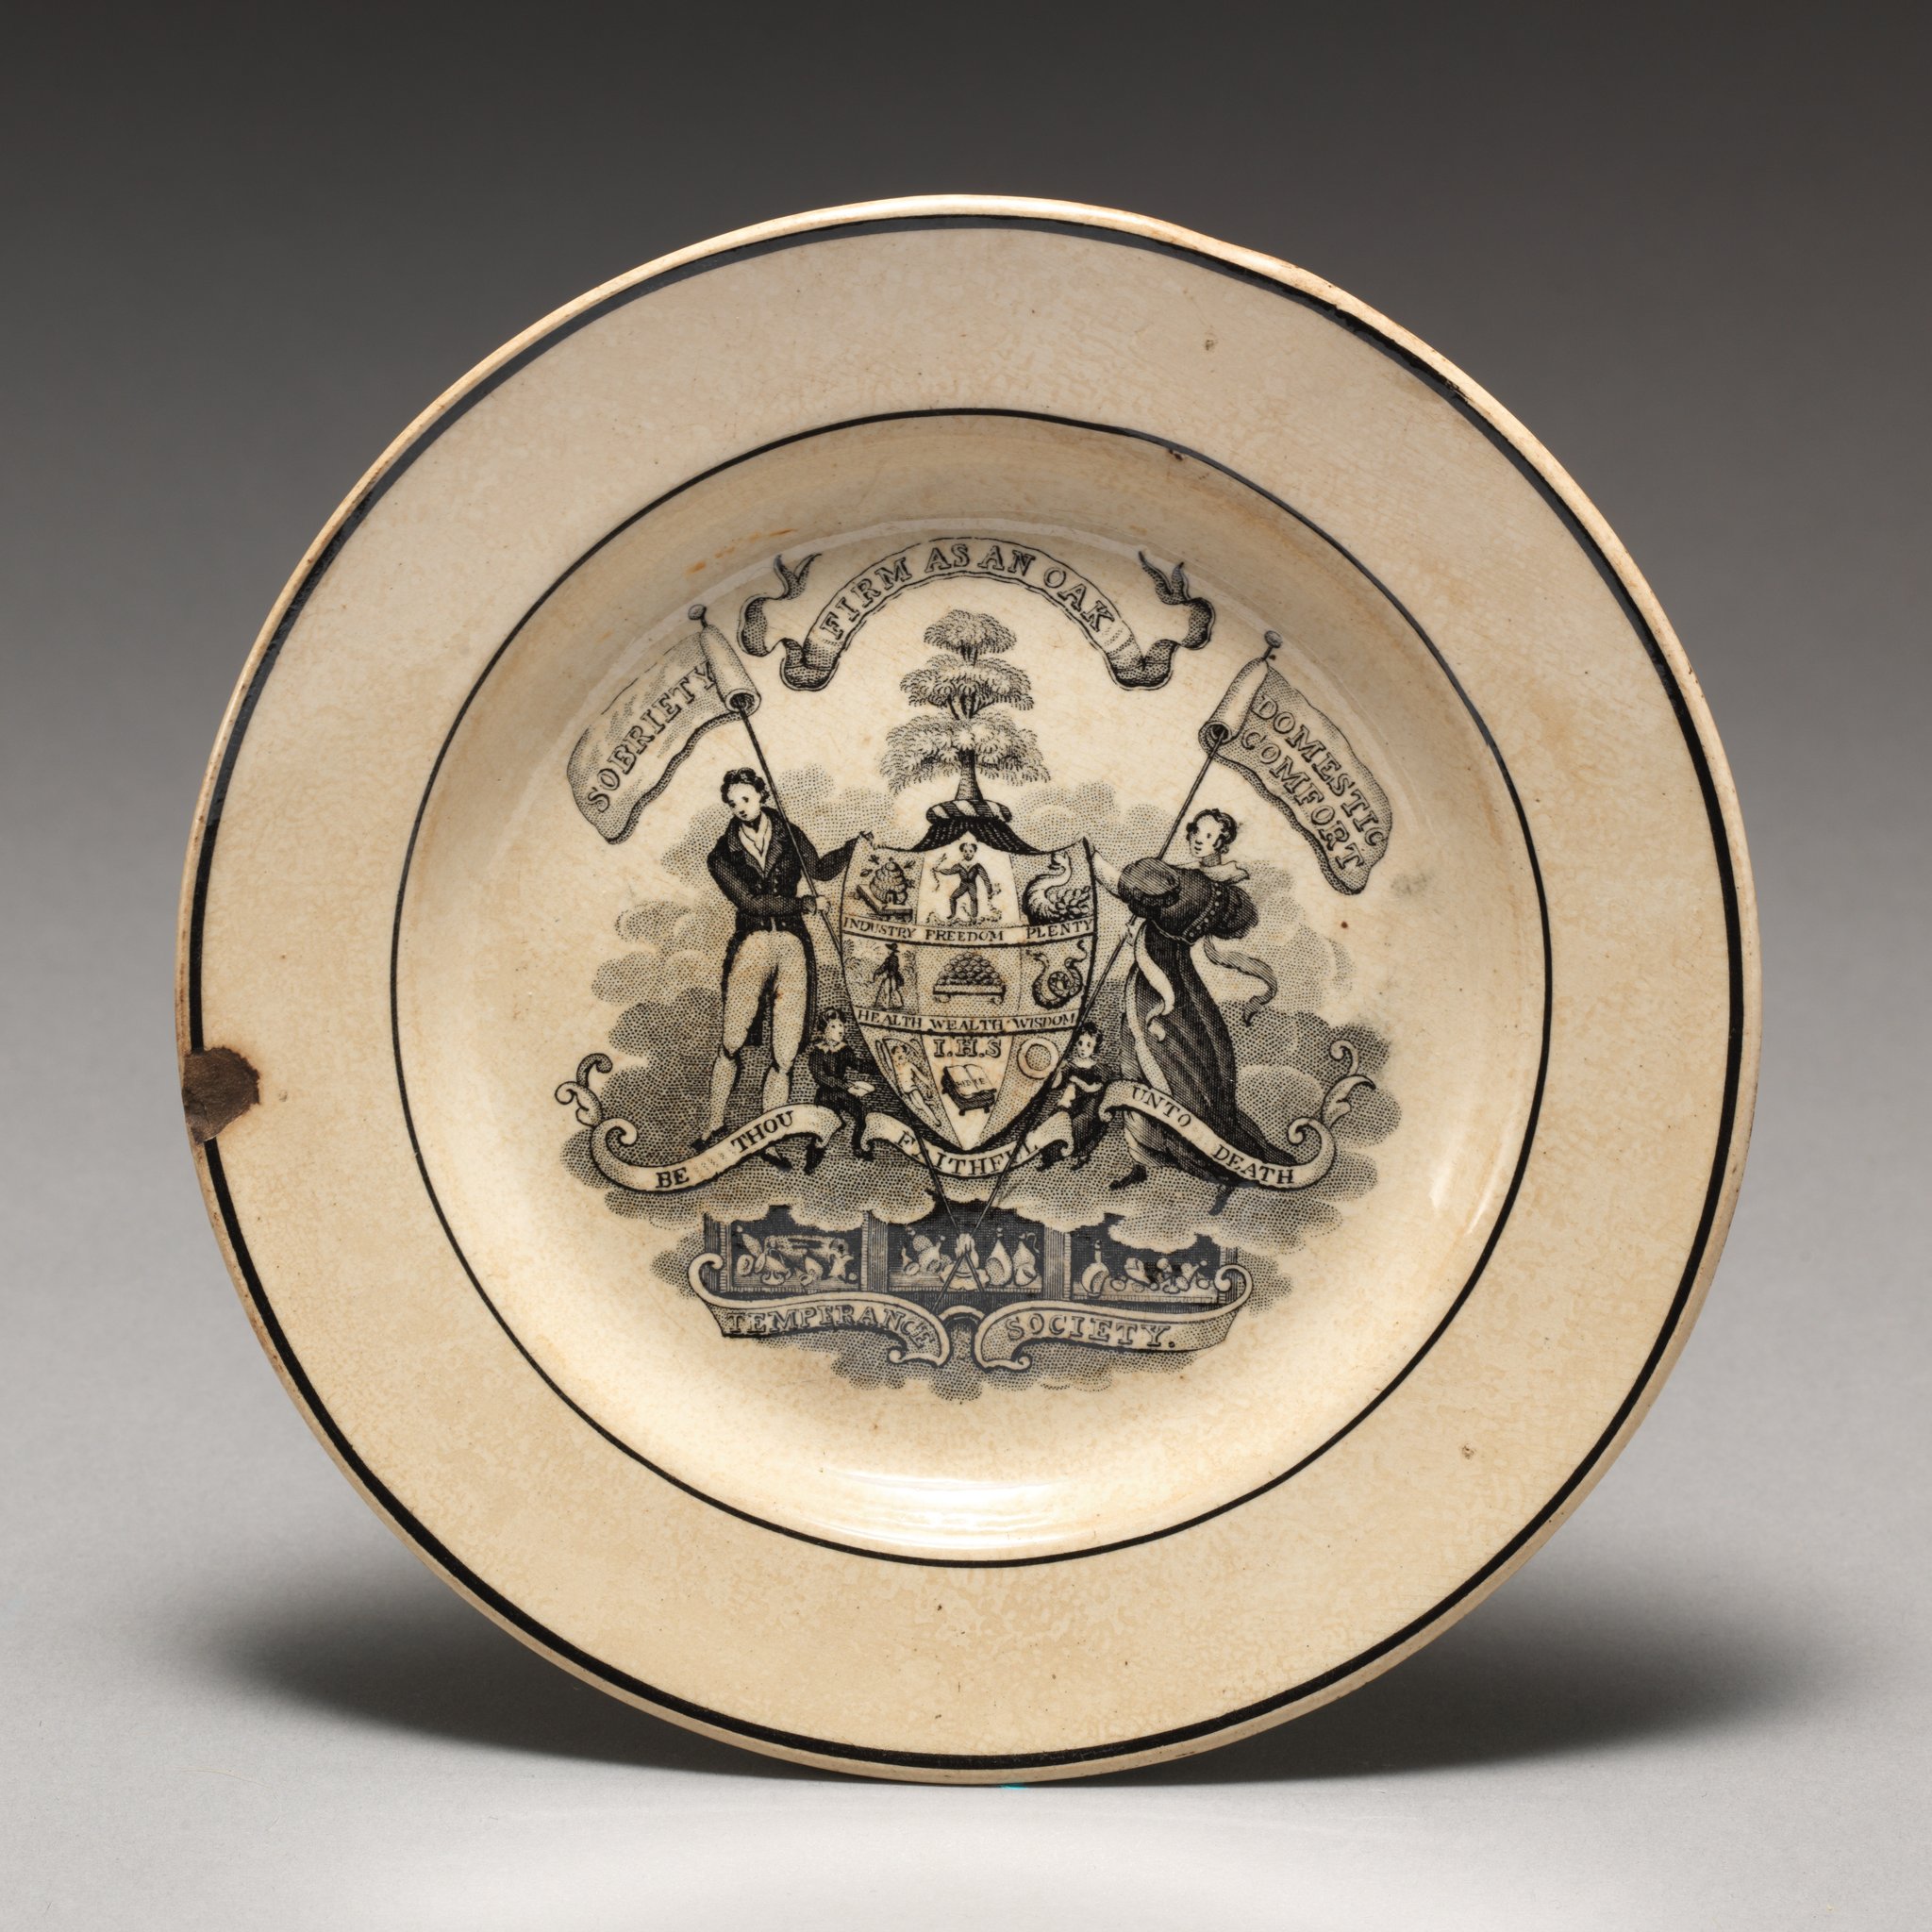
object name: plate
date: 1801-1900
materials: pottery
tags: men,women,coat of arms,flags